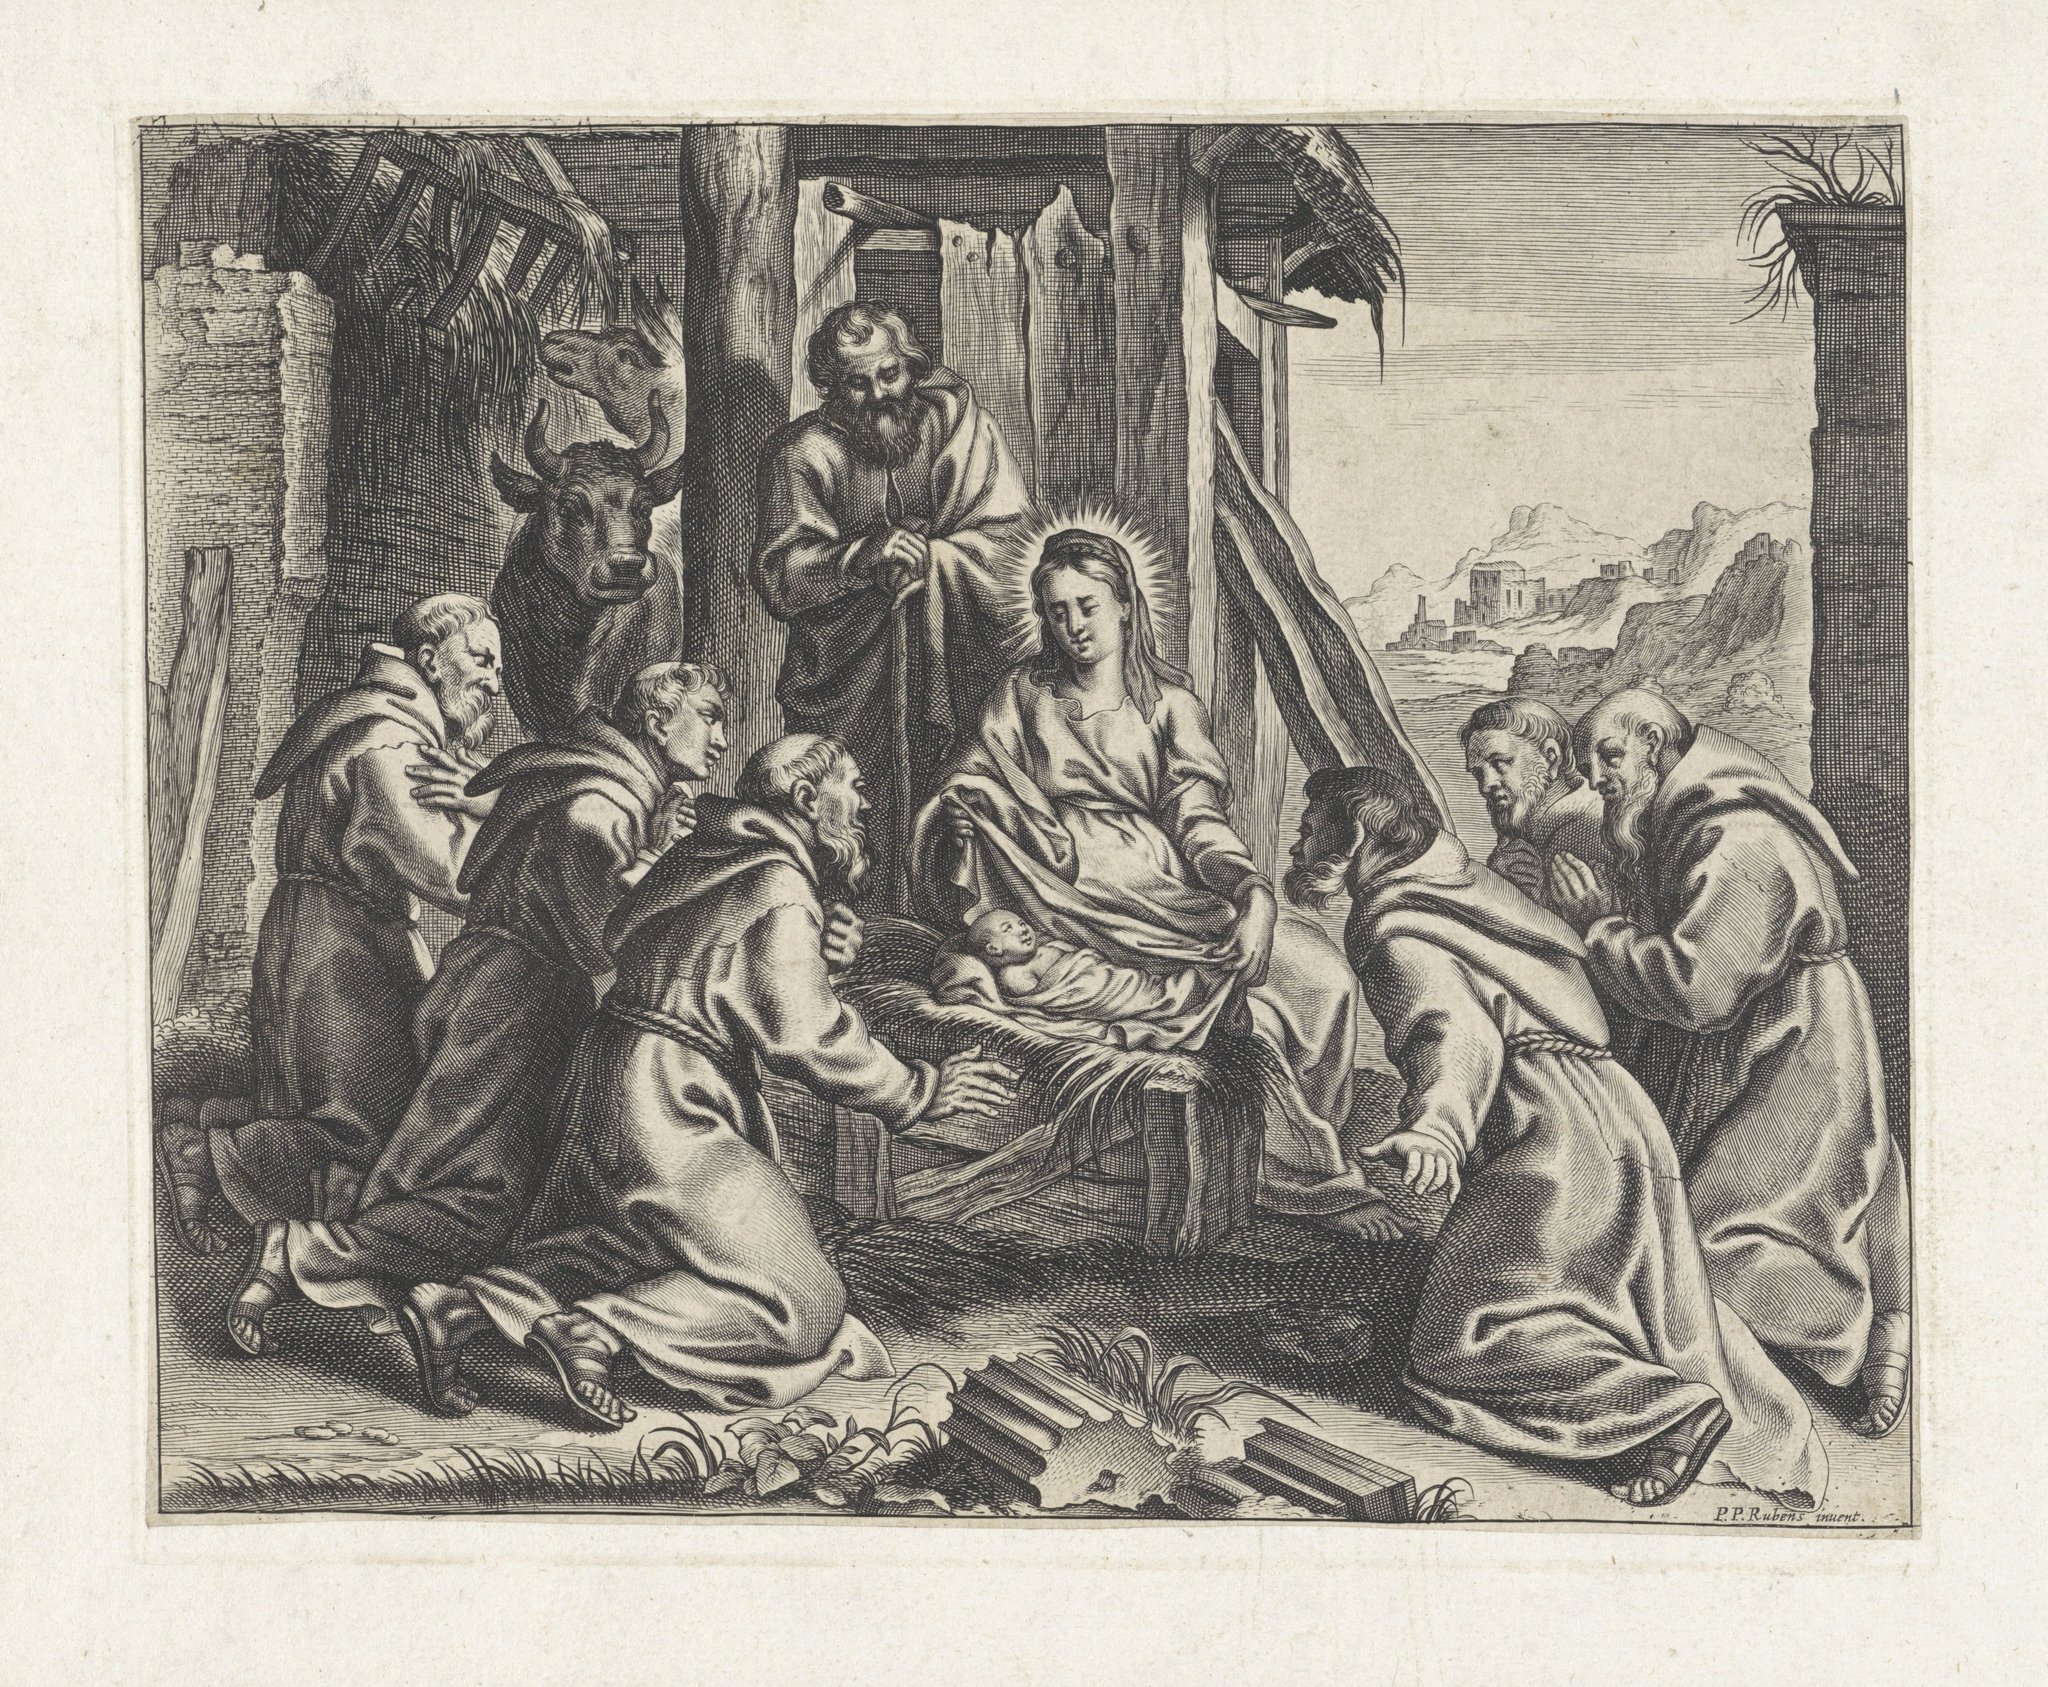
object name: print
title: Aanbidding van het Christuskind door monniken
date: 1598-1690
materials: paper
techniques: engraving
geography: antwerp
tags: adoration of the christ-child ~ christ's birth, monk(s), friar(s)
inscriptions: collector's mark: Lugt 240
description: Maria zit naast Christus, die in de kribbe ligt, en toont hem aan een groep knielende monniken. Jozef kijkt toe. Achter hem de os en de ezel. In de verte een berglandschap.